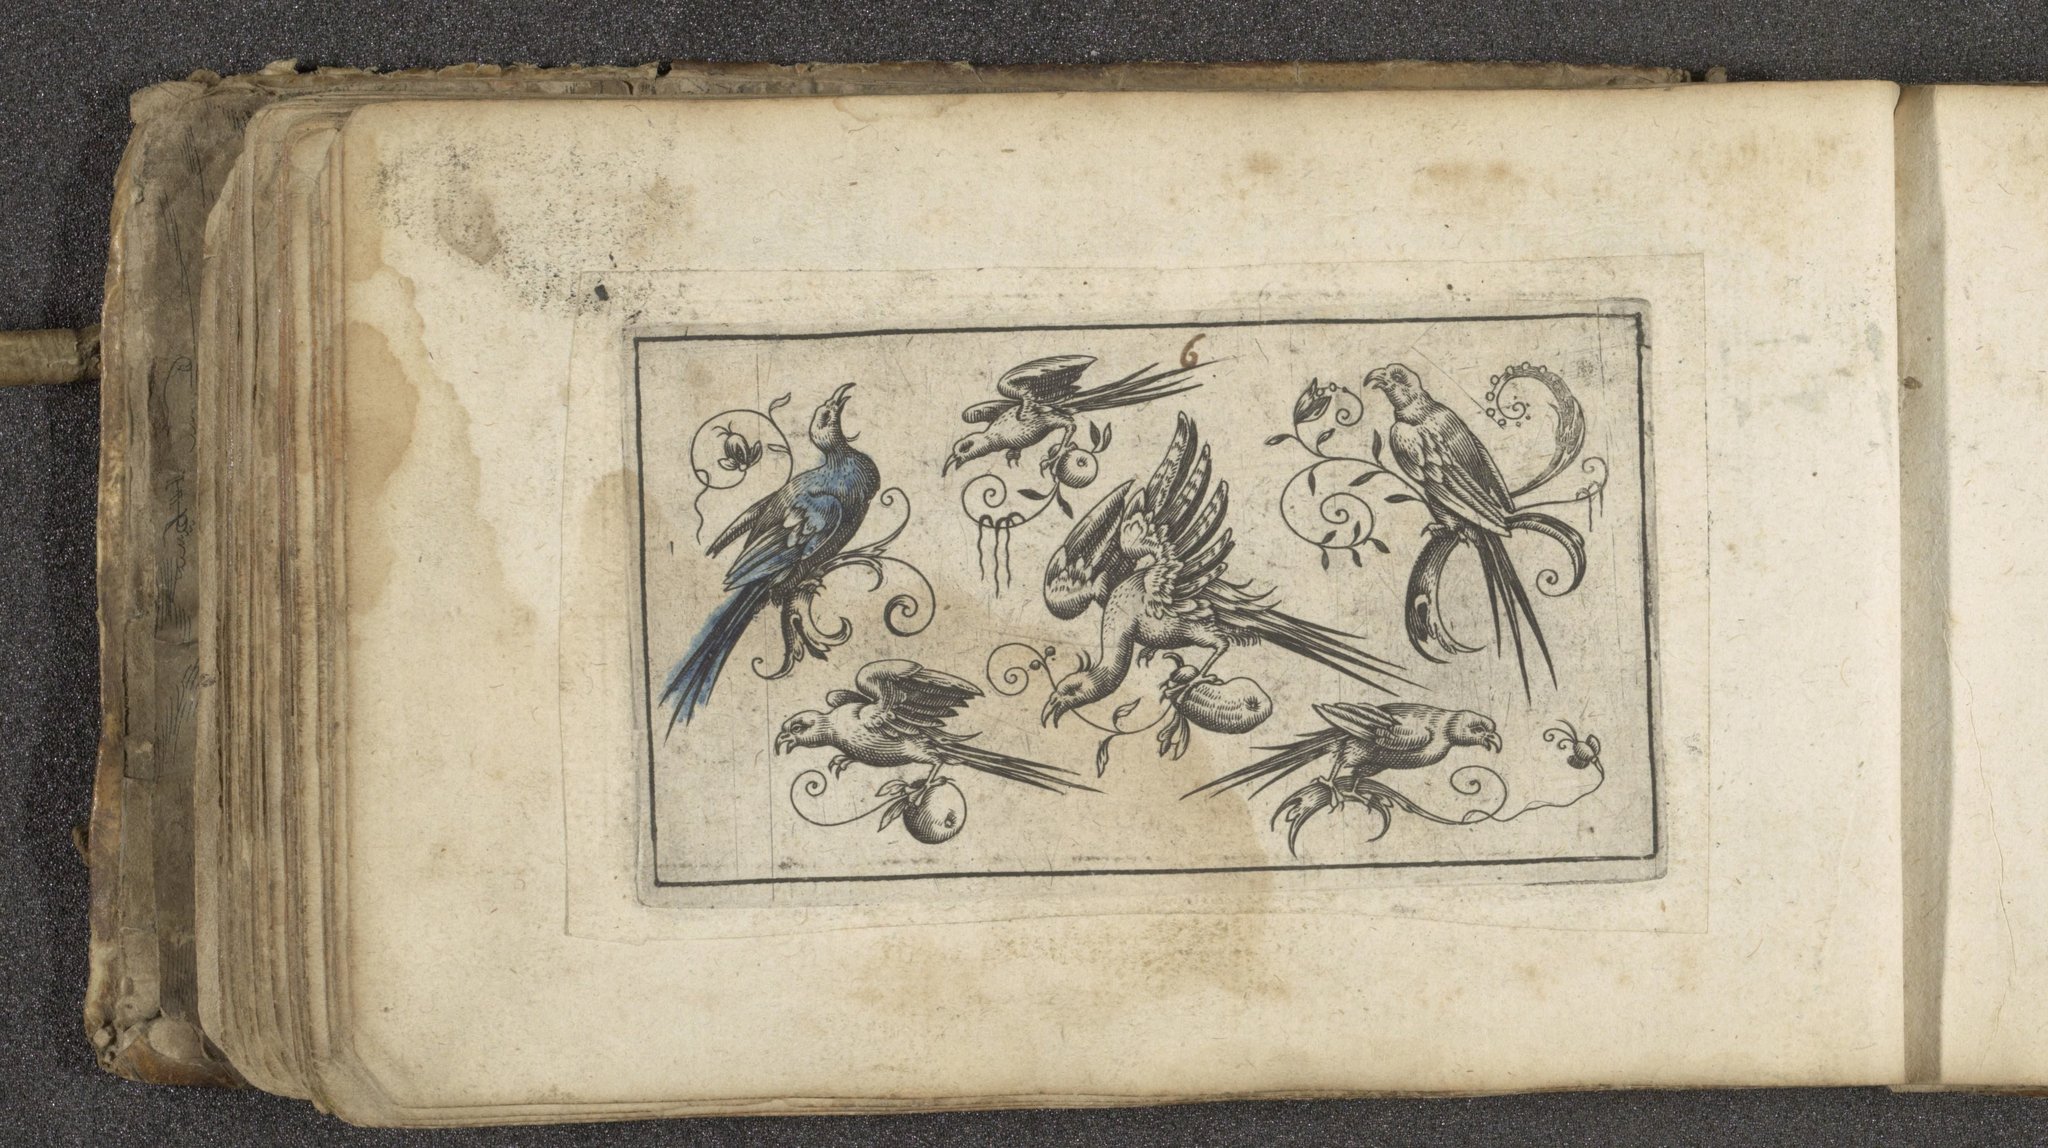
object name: album leaf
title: Vogels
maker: Anonymous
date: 1601-1650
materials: paper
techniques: colour, engraving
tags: birds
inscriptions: inscription: ‘59’, inscription: ‘6’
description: Zes vogels op takken met ranken en fruit. De prent maakt deel uit van een album.